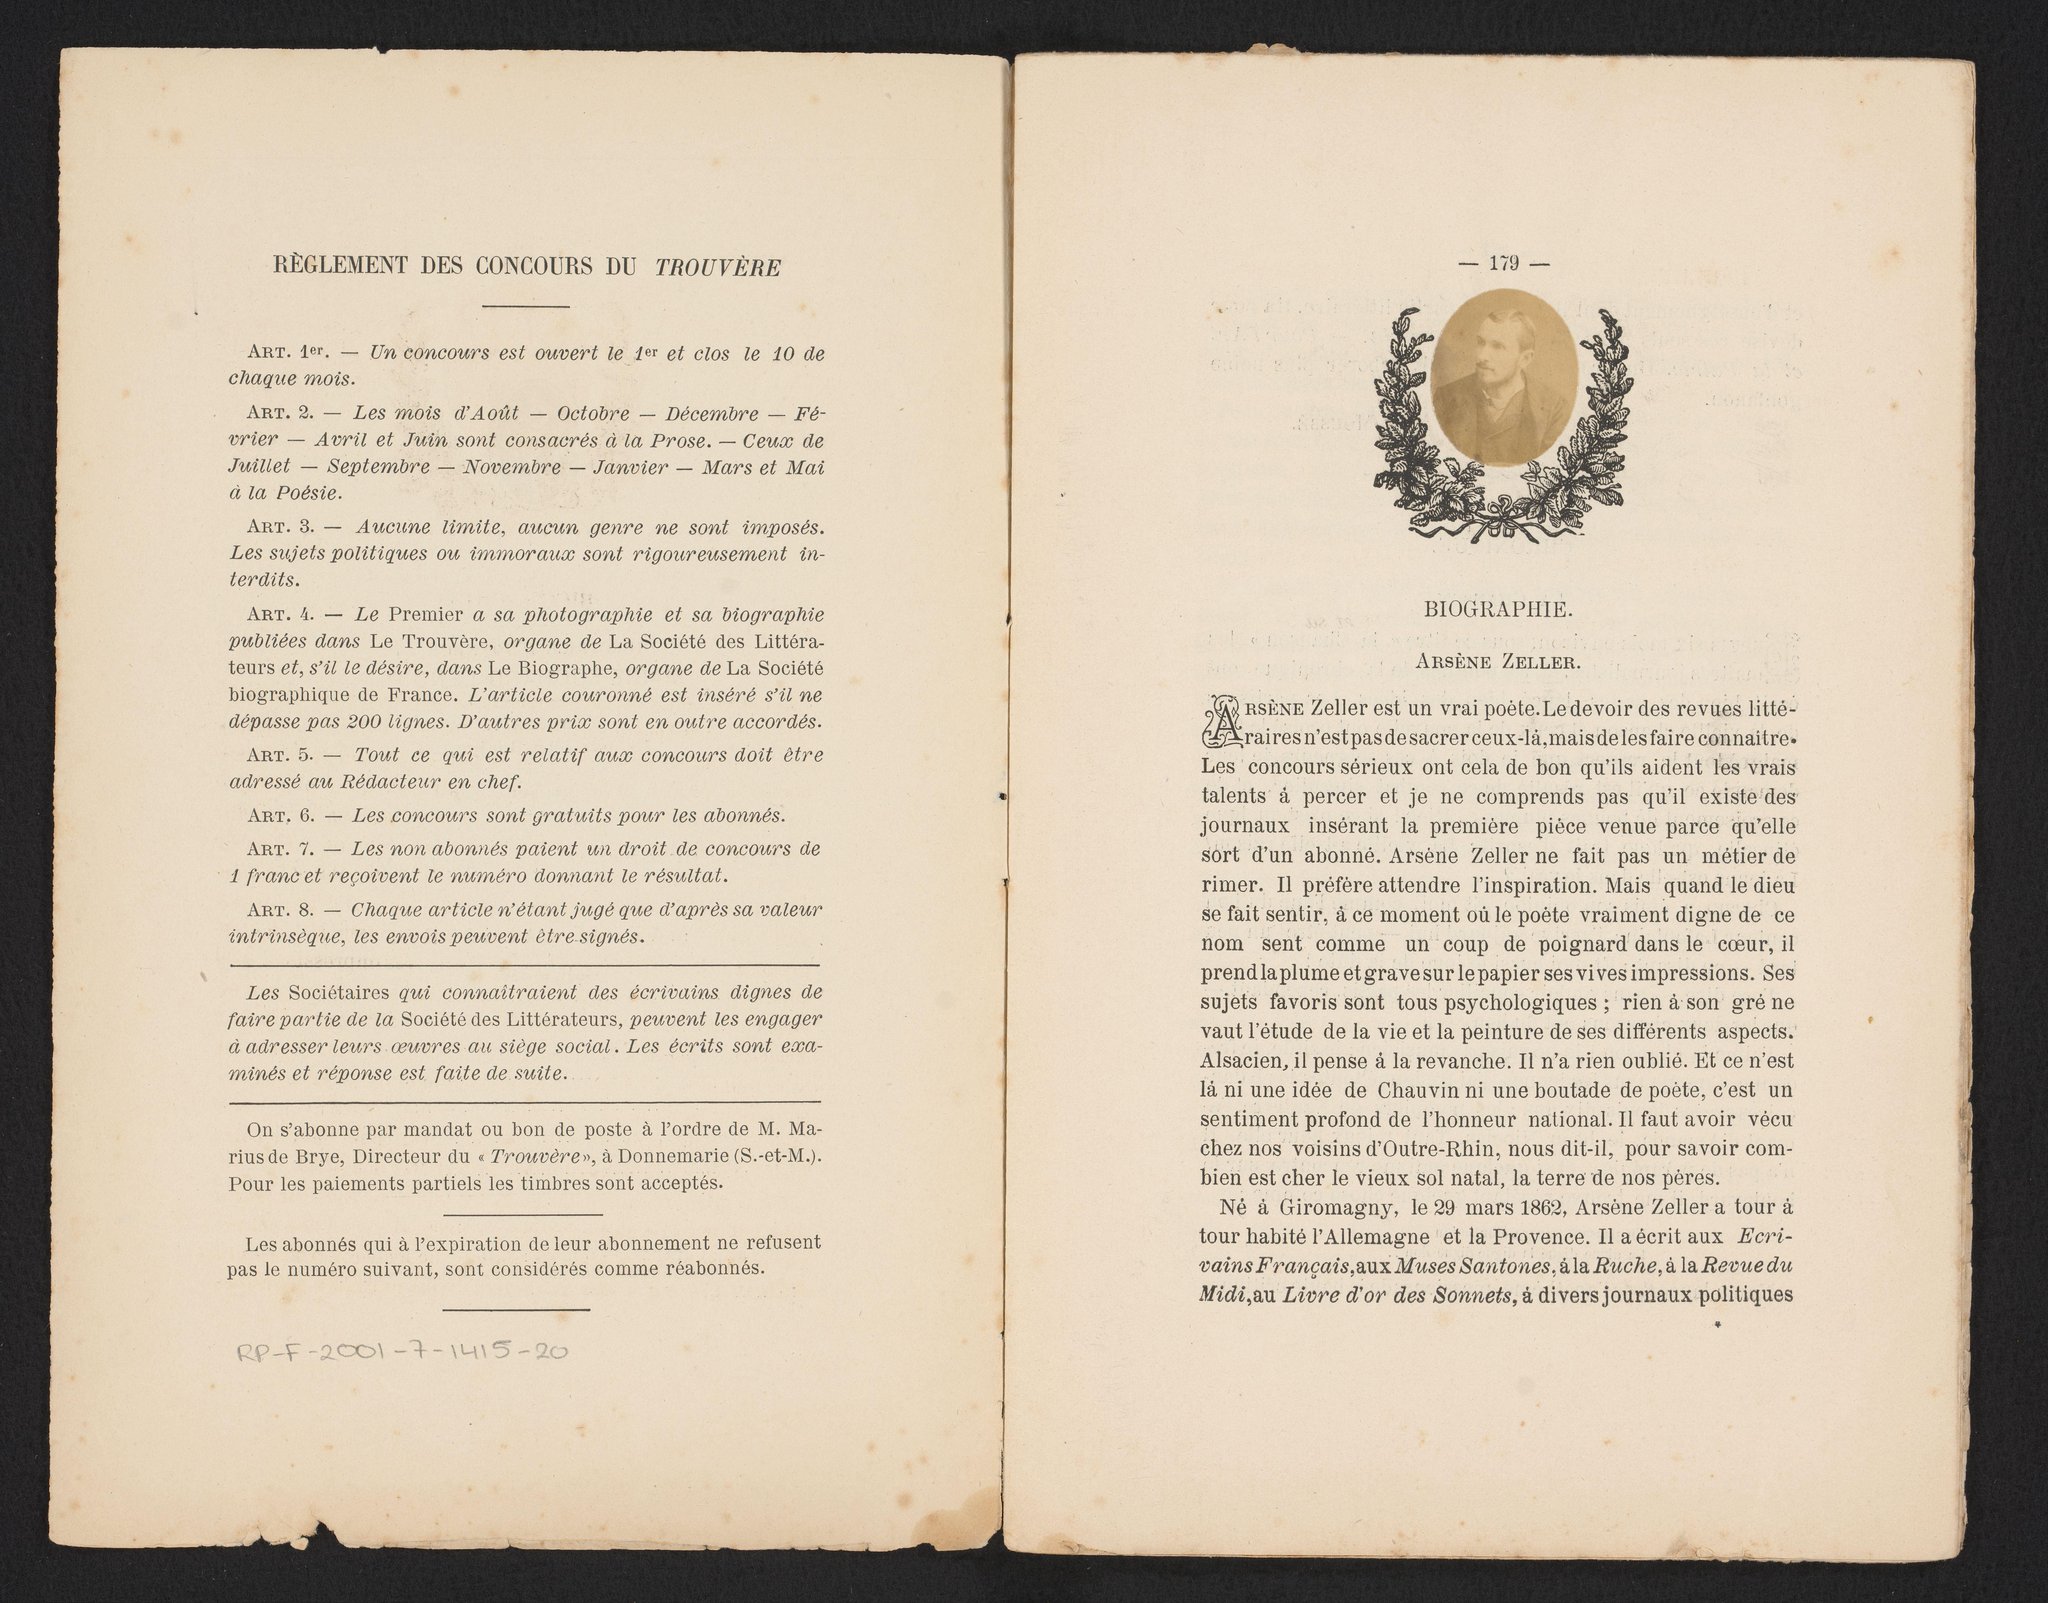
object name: page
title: Portret van Ansène Zeller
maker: Anonymous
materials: photographic support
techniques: albumen print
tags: historical persons